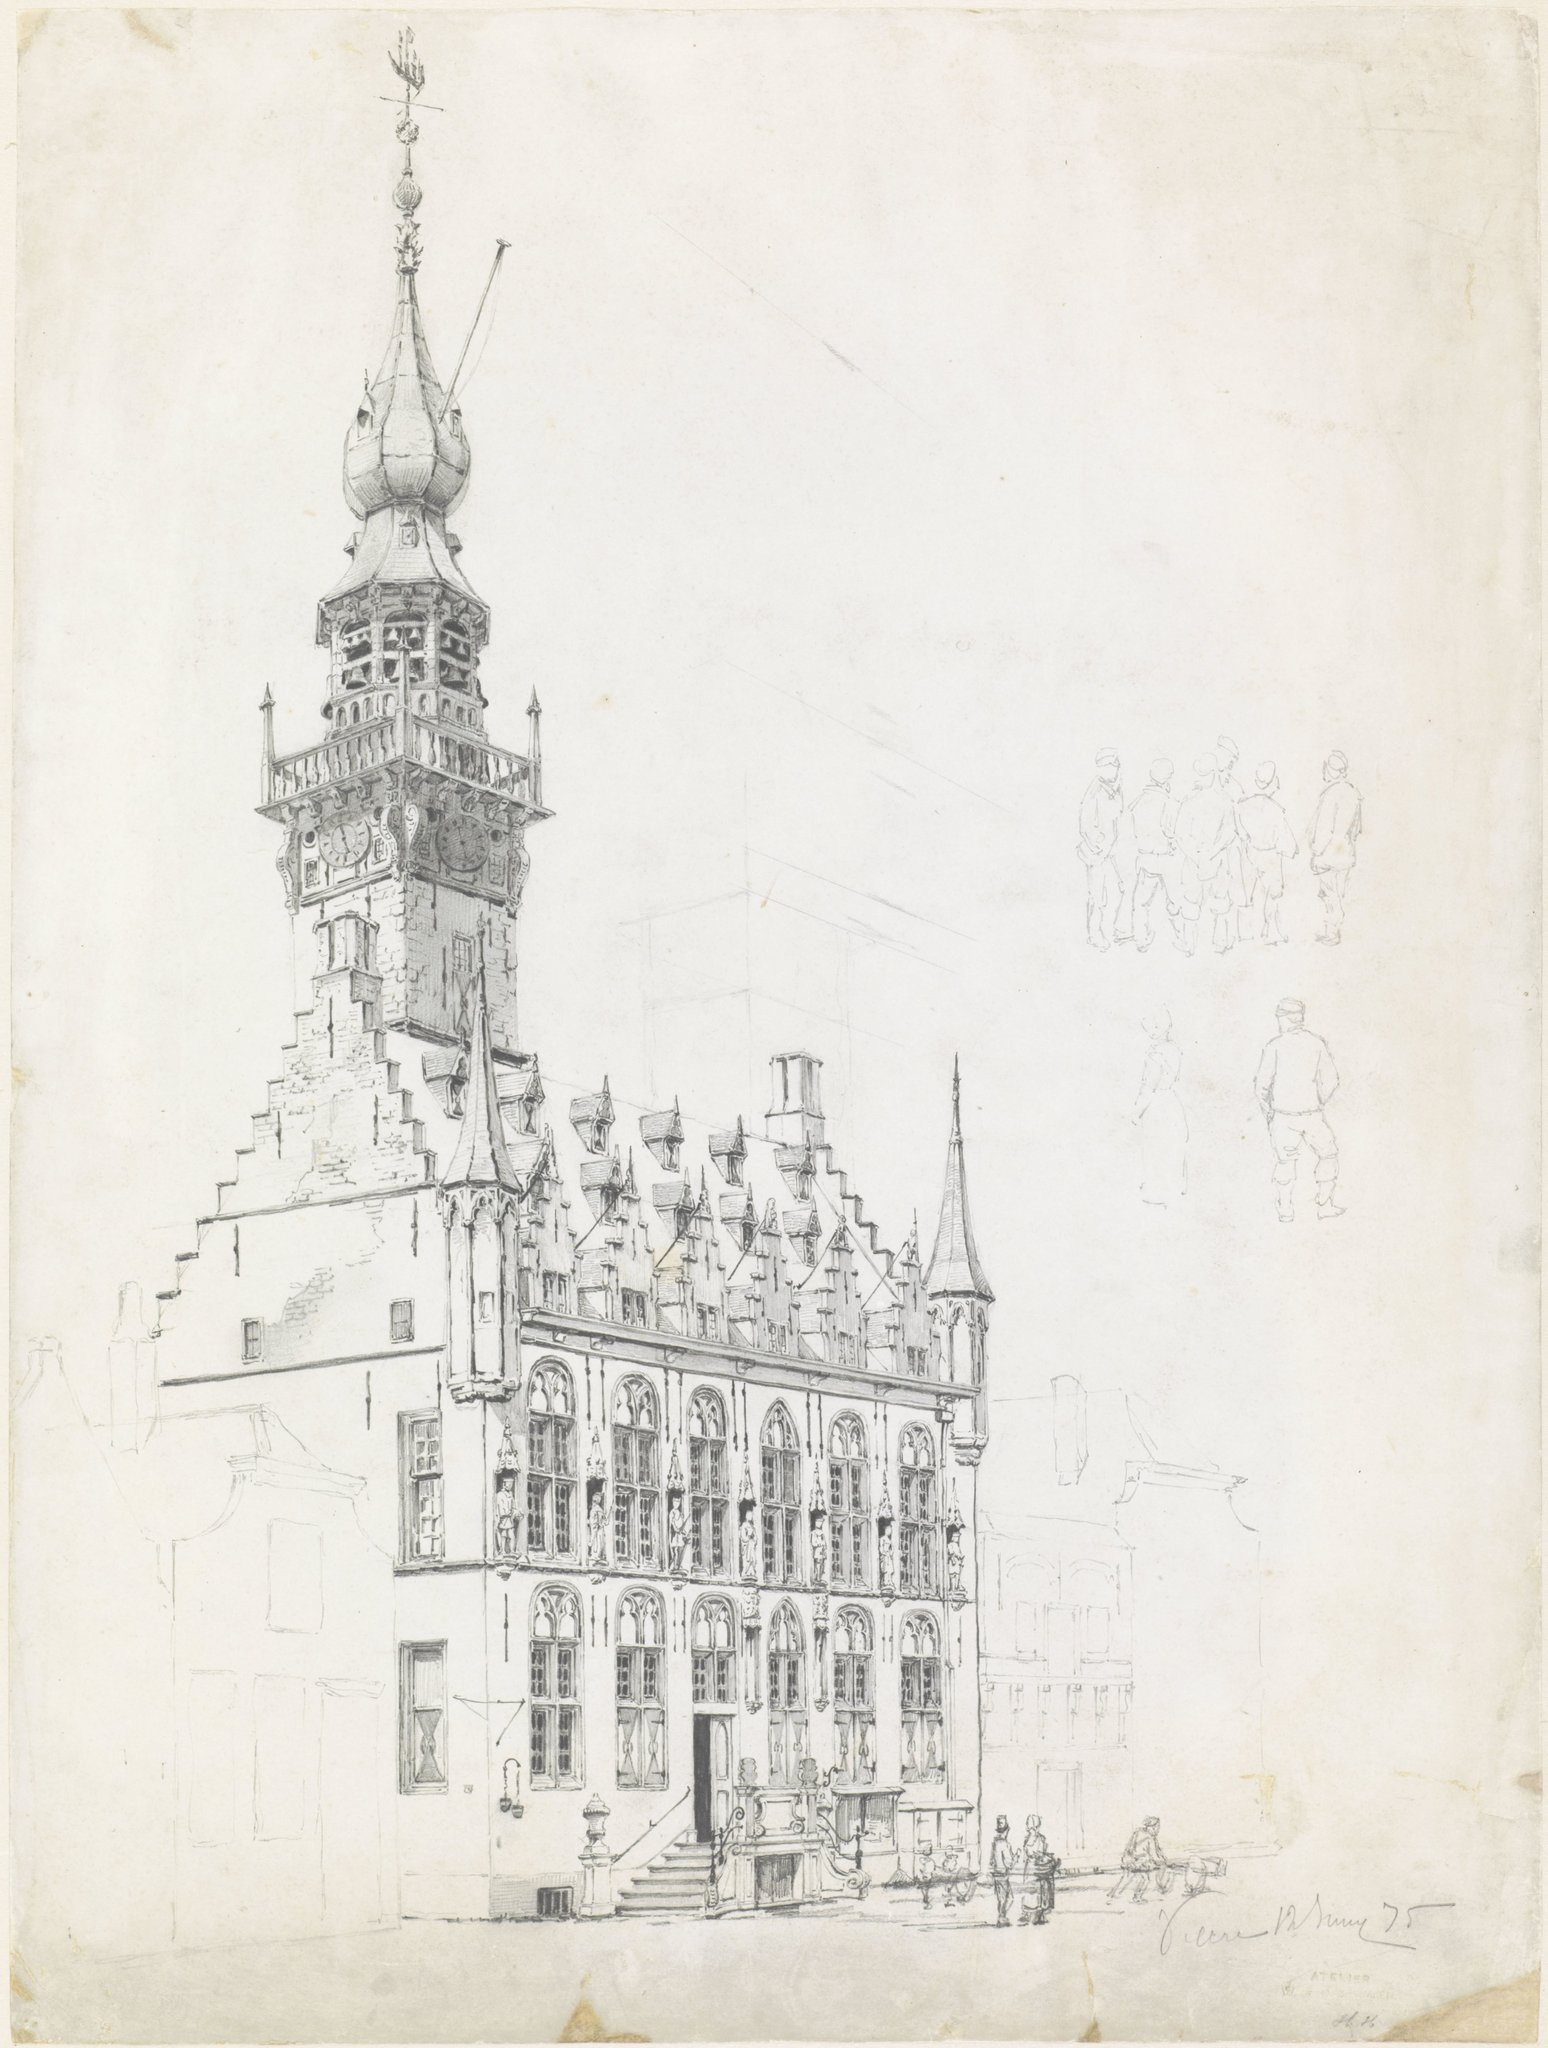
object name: drawing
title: Stadhuis van Veere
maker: willem de haas hemken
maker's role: draughtsman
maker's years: 1831-1911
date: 1875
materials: paper, pencil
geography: veere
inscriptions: date: ‘12 Juny 75’, annotation: ‘Veere’